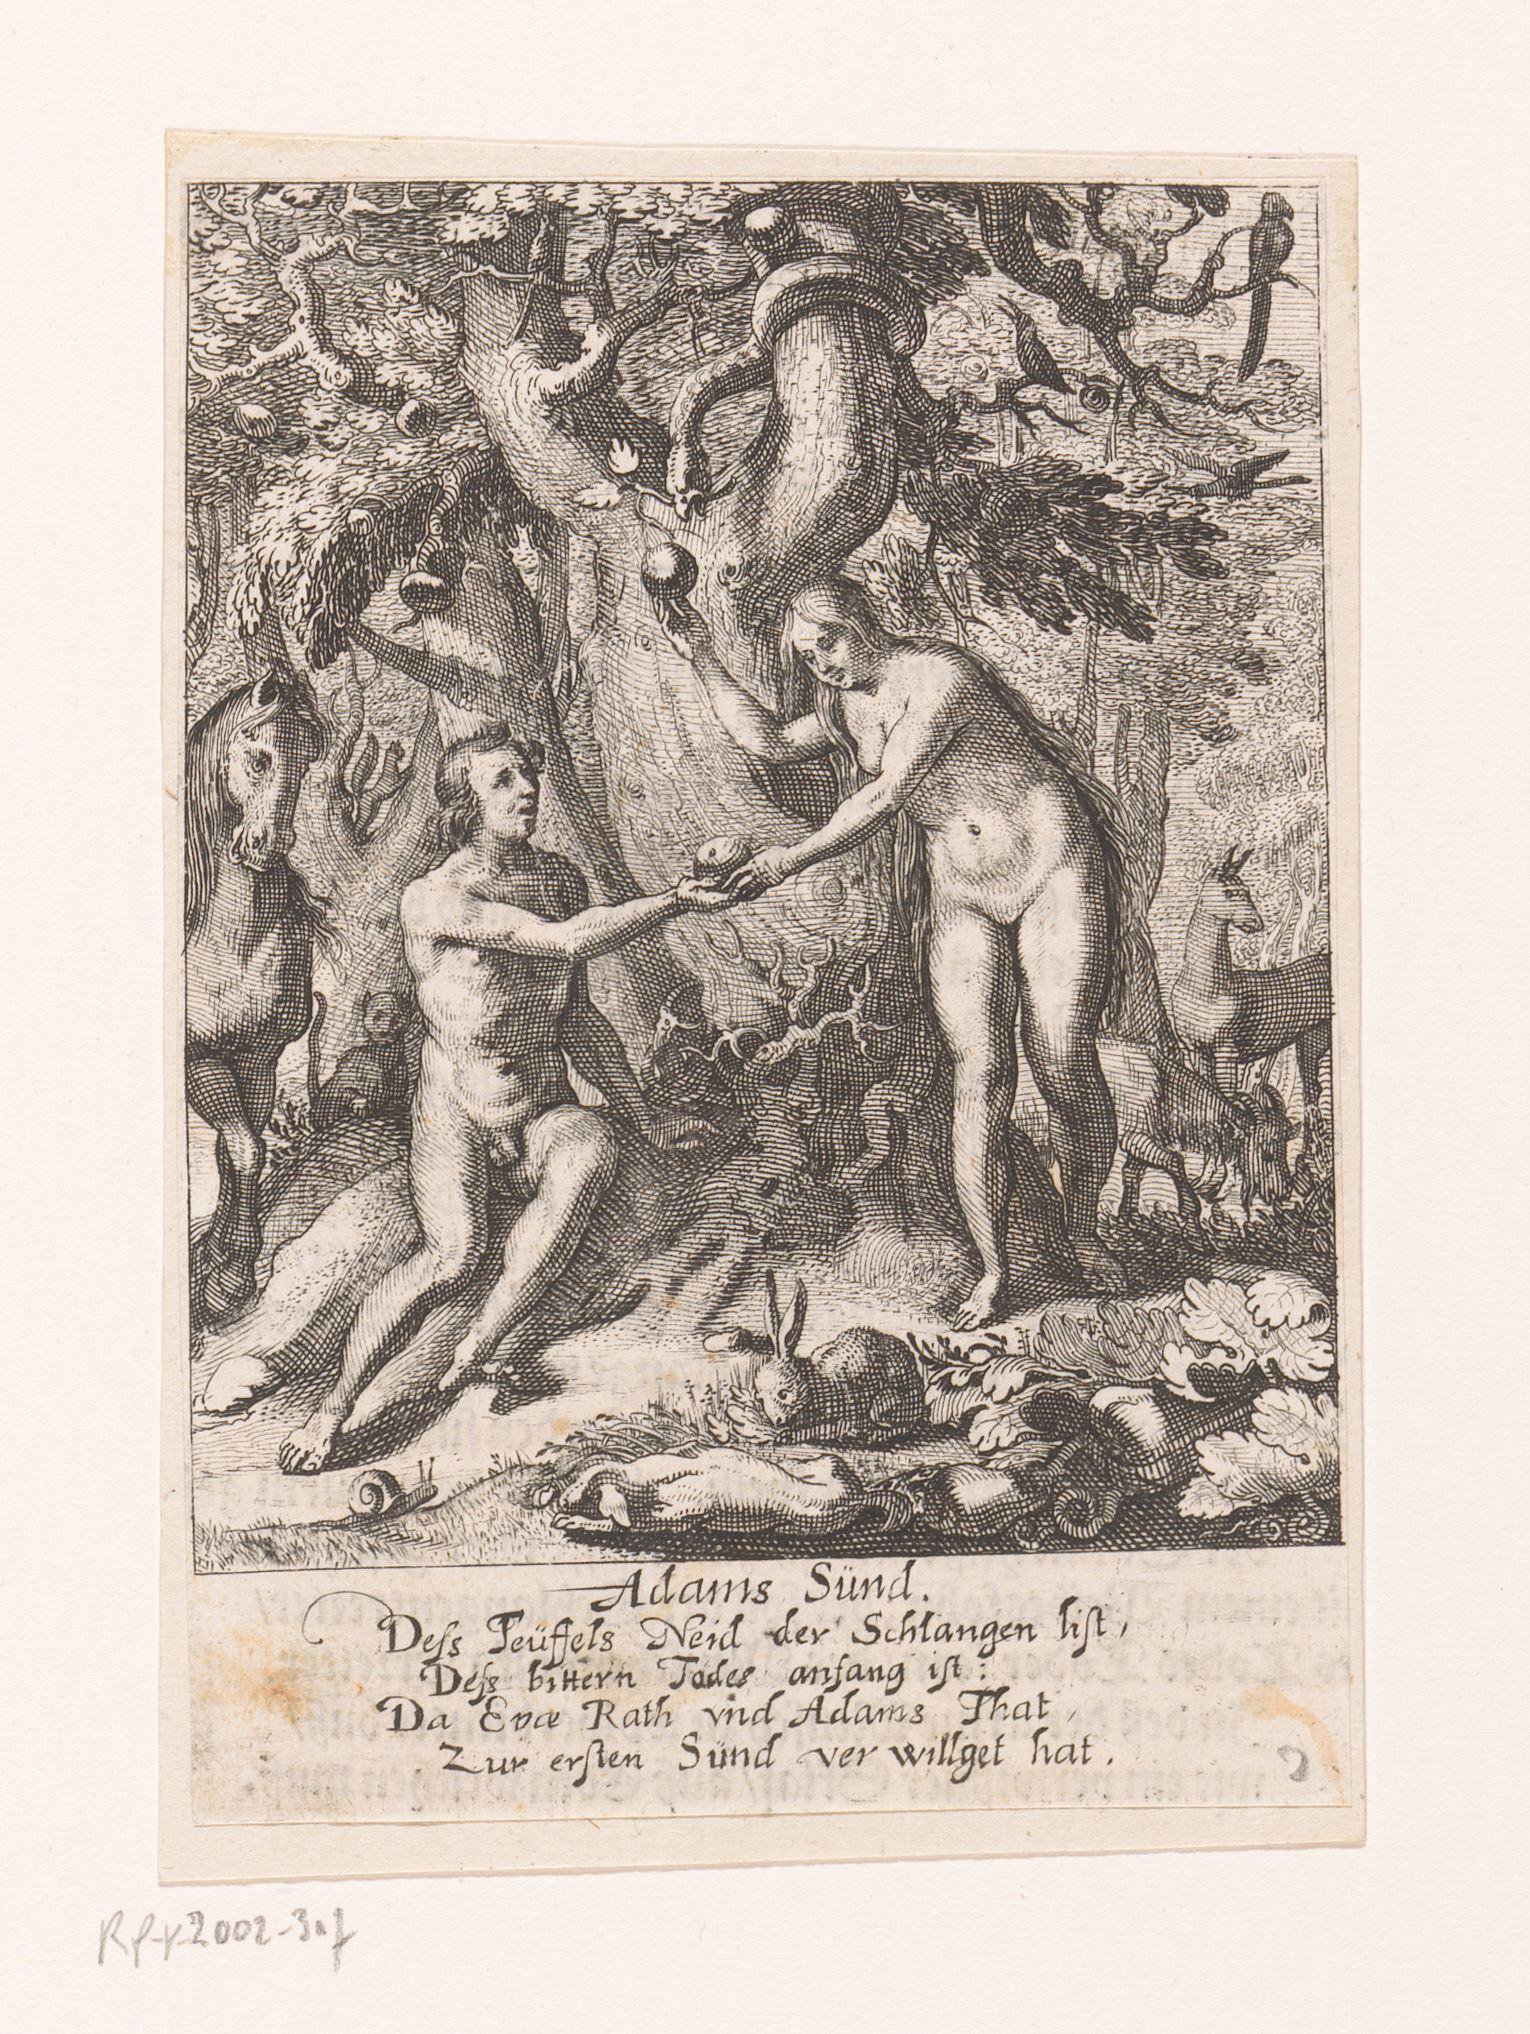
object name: print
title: Adams Sünd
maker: johann jakob bodmer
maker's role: printer, publisher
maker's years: 1629-1650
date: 1650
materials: paper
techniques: etching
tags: dance of death; death together with one or more human beings, temptation and fall (genesis 3:1-7)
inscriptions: collector's mark: Lugt 2228, collector's mark: Lugt 2760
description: Prent uit: Meyer, Rudolph. Sterbenspiegel, das ist sonnenklare Vorstellung menschlicher Nichtigkeit durch alle Ständ und Geschlechter (...). Zürich: J.J. Bodmer, 1650.